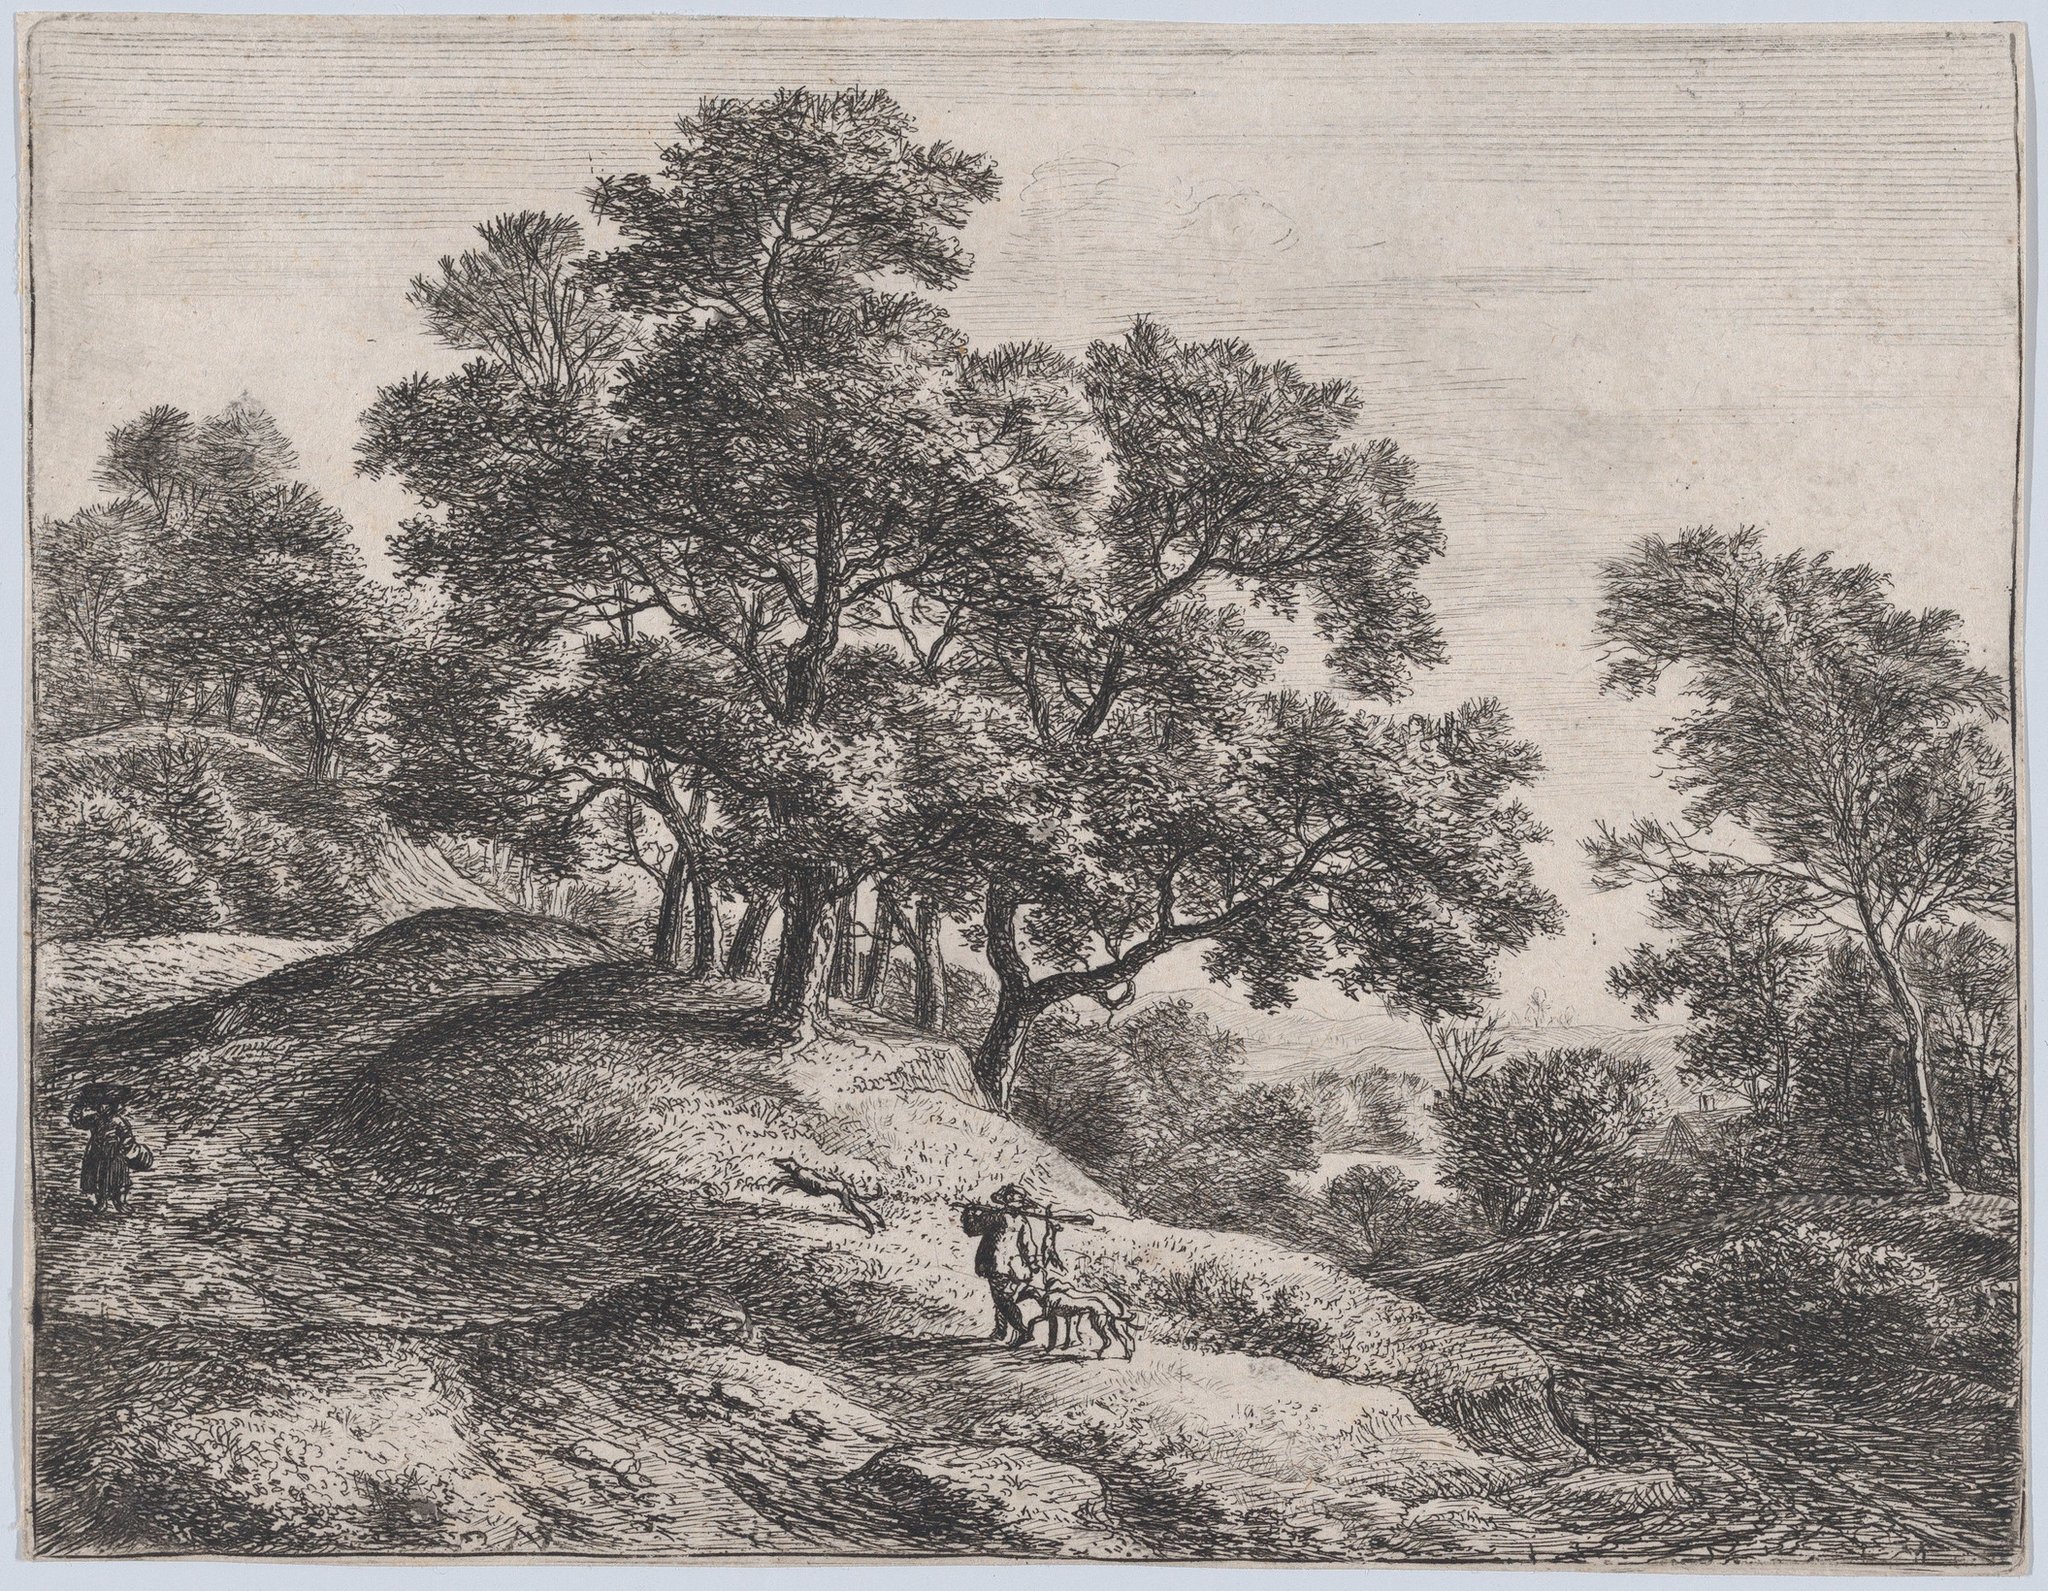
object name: print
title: The Rabbit Hunter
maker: anthonie waterloo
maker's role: artist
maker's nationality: dutch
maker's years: 1609-1690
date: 1601-1700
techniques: etching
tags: men,dogs,trees